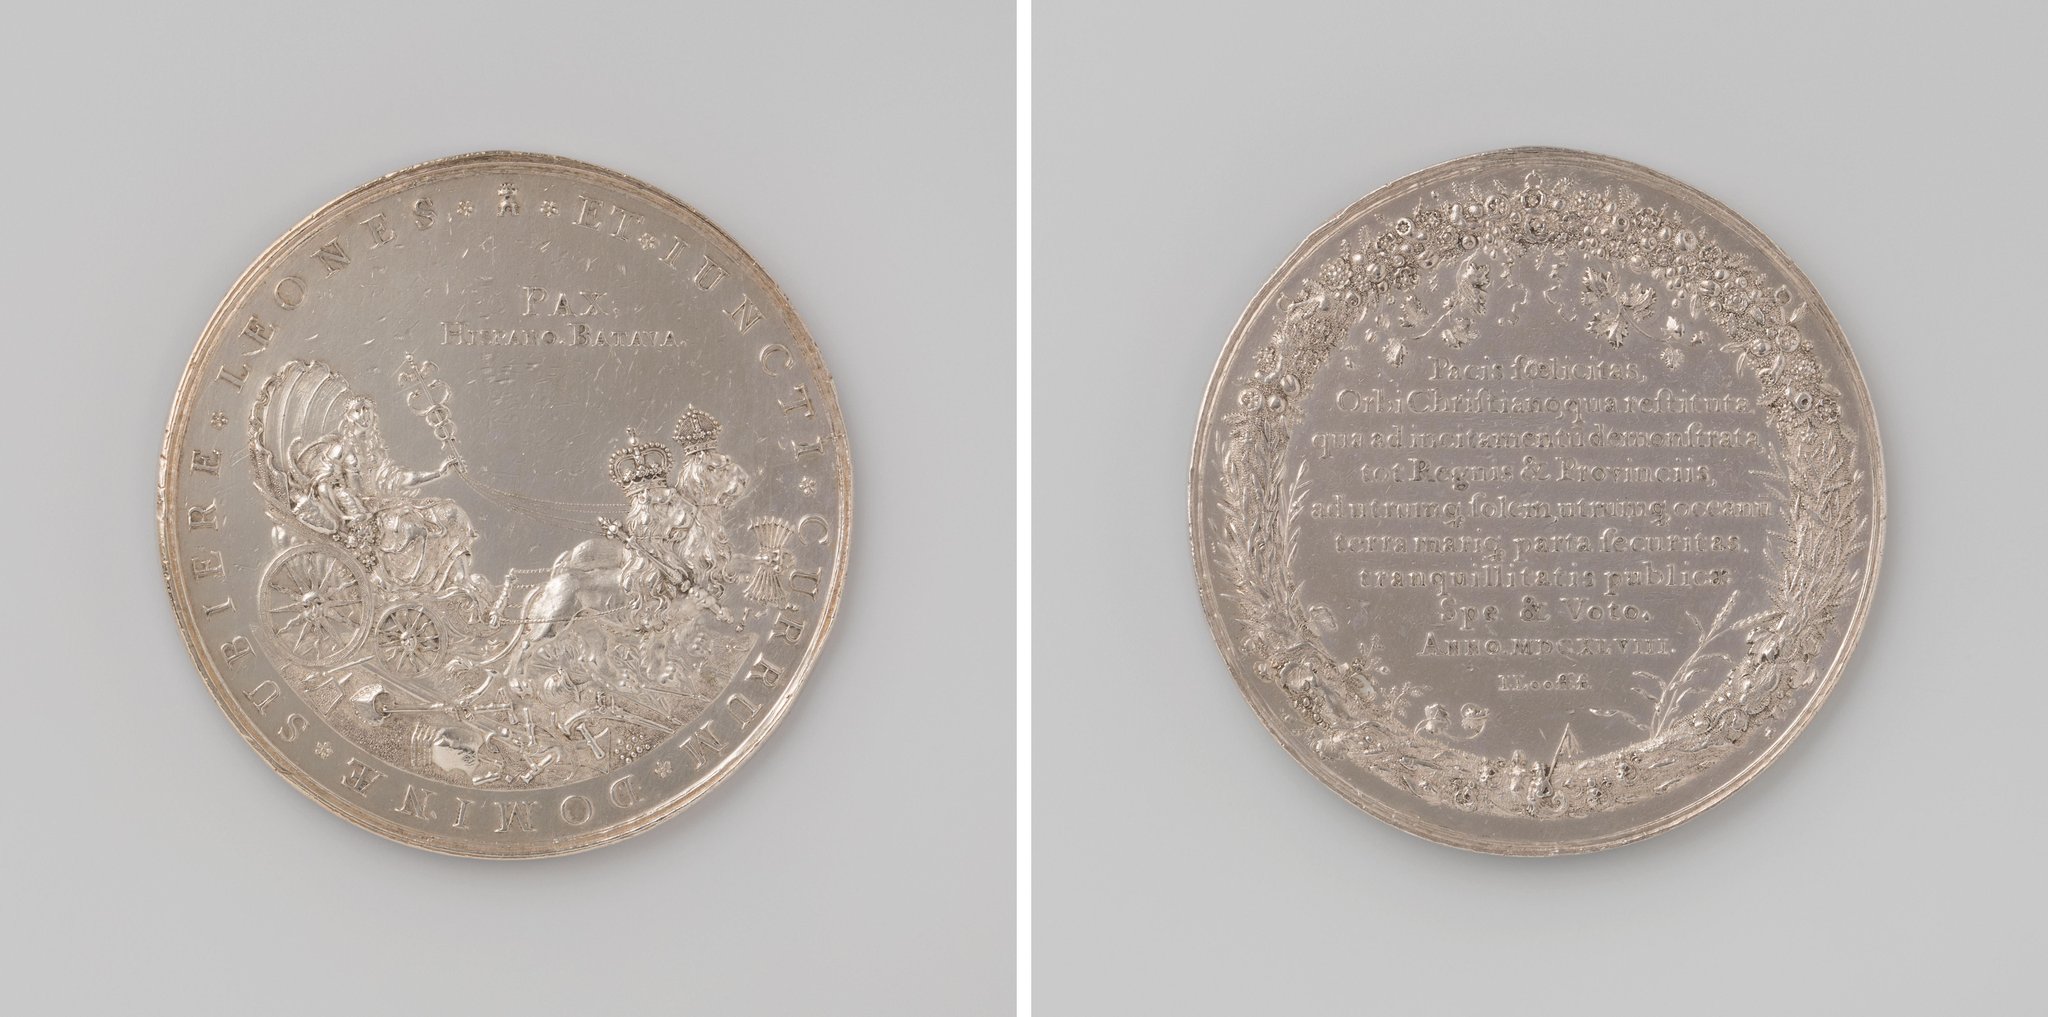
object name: medal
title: Penning over de Vrede van Munster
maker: johannes looff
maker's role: die cutter, draughtsman, print maker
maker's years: -1651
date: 1648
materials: silver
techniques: striking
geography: middelburg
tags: münster, noordrijn-westfalen, vrede van münster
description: Zilveren penning. Voorzijde: Vrede met Mercuriusstaf en hoorn van overvloed op zegewagen getrokken door twee gekroonde leeuwen onder opschrift binnen omschrift. Keerzijde: opschrift binnen krans van bloemen, vruchten en bladeren.